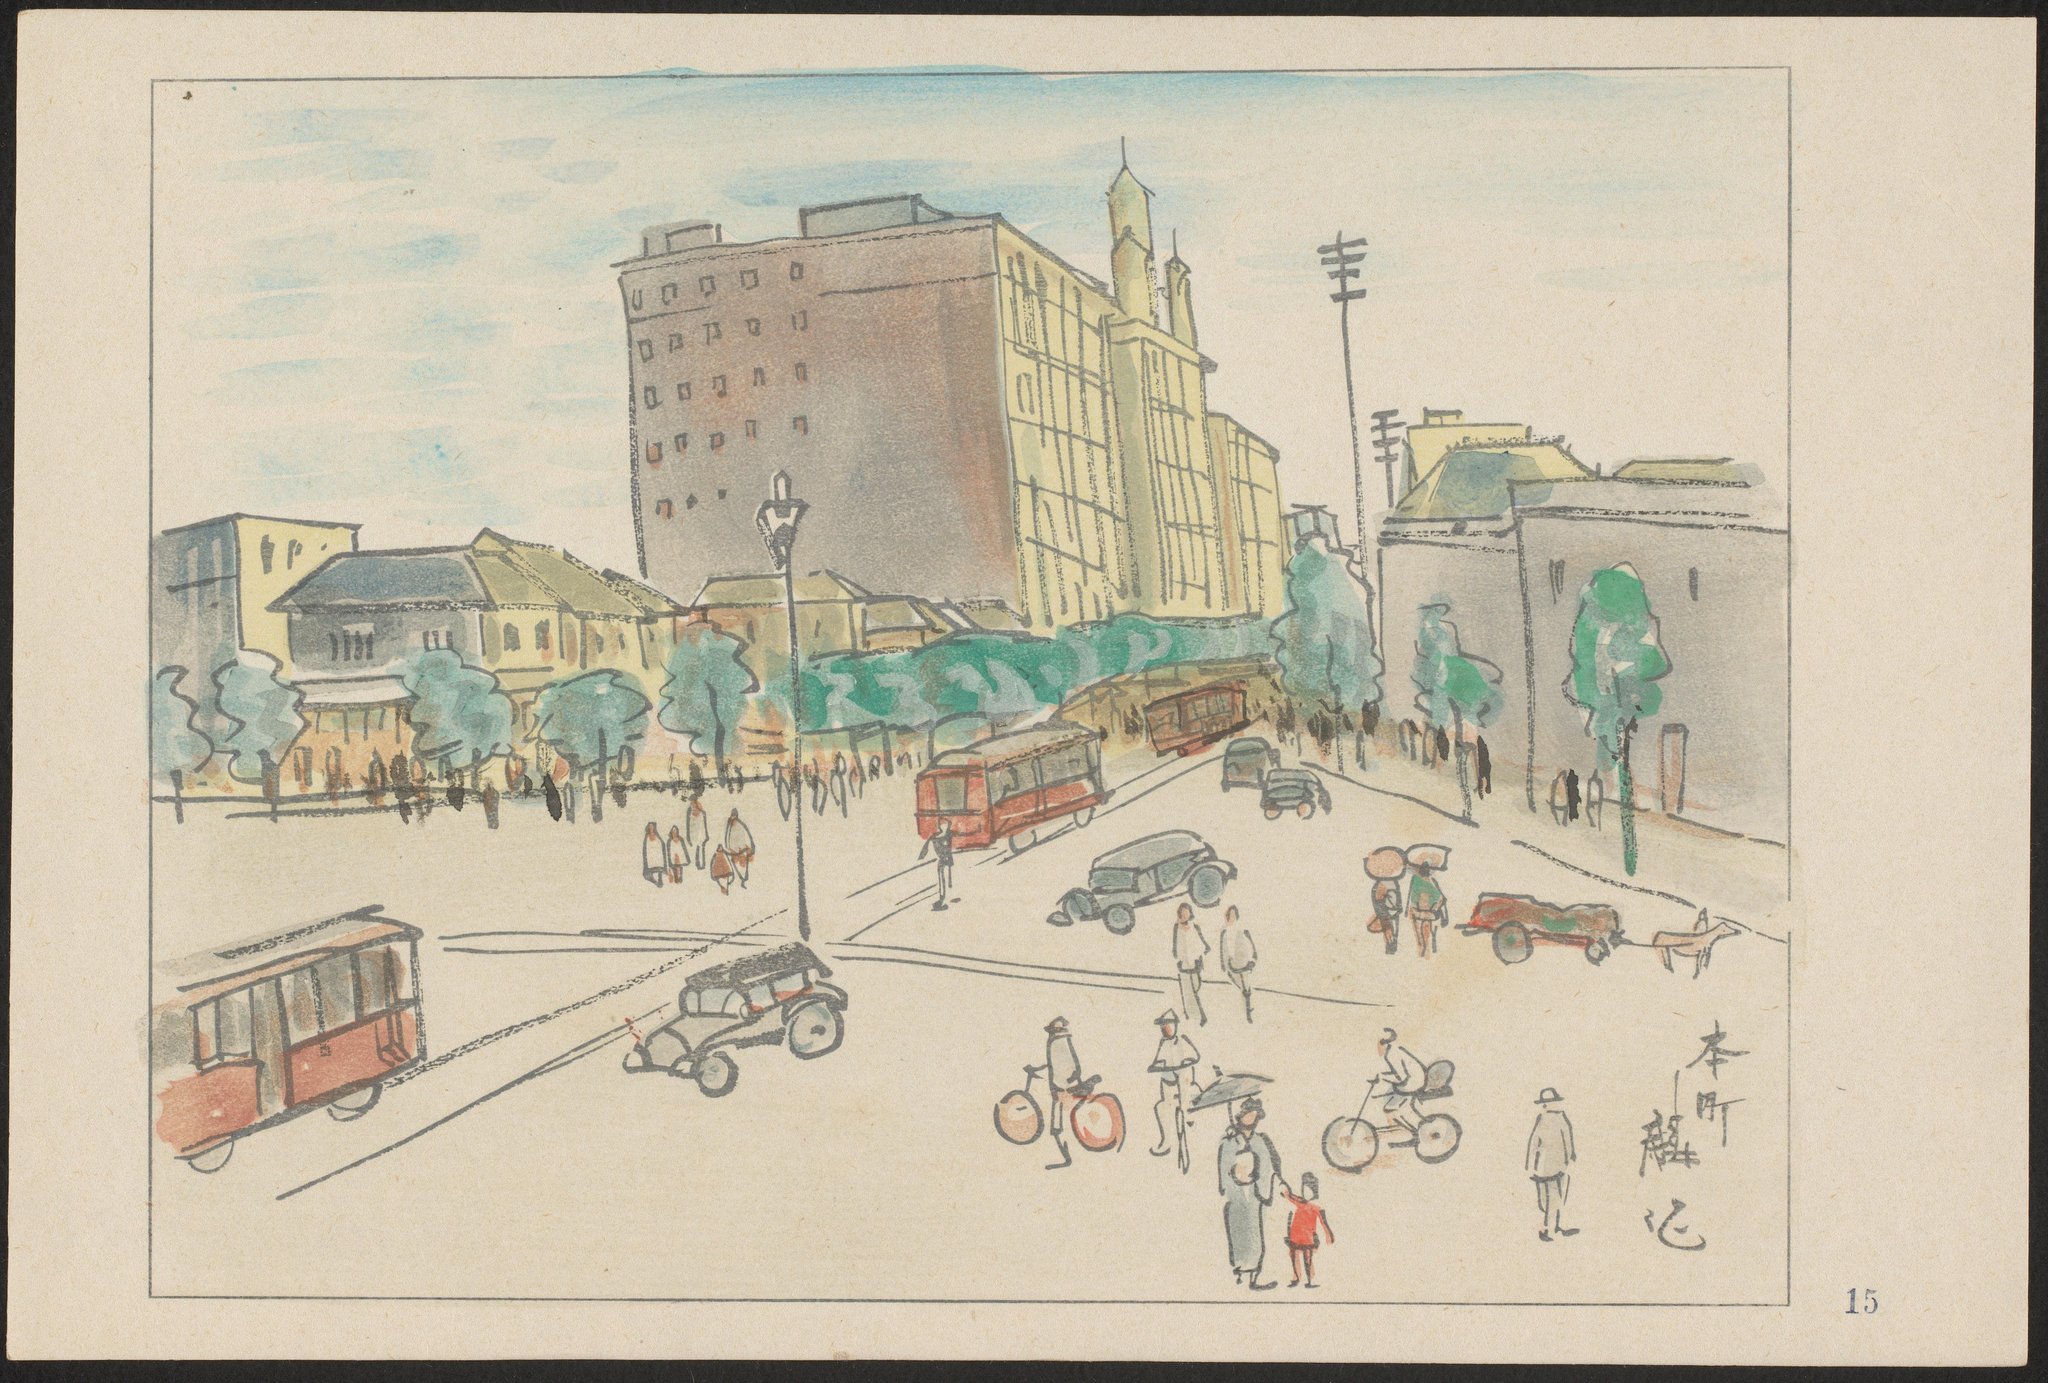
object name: print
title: Honmachi, a business center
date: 1947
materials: paper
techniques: woodcut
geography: japan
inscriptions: date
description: Een drukke straat met trams en auto's in het centrum van Osaka.